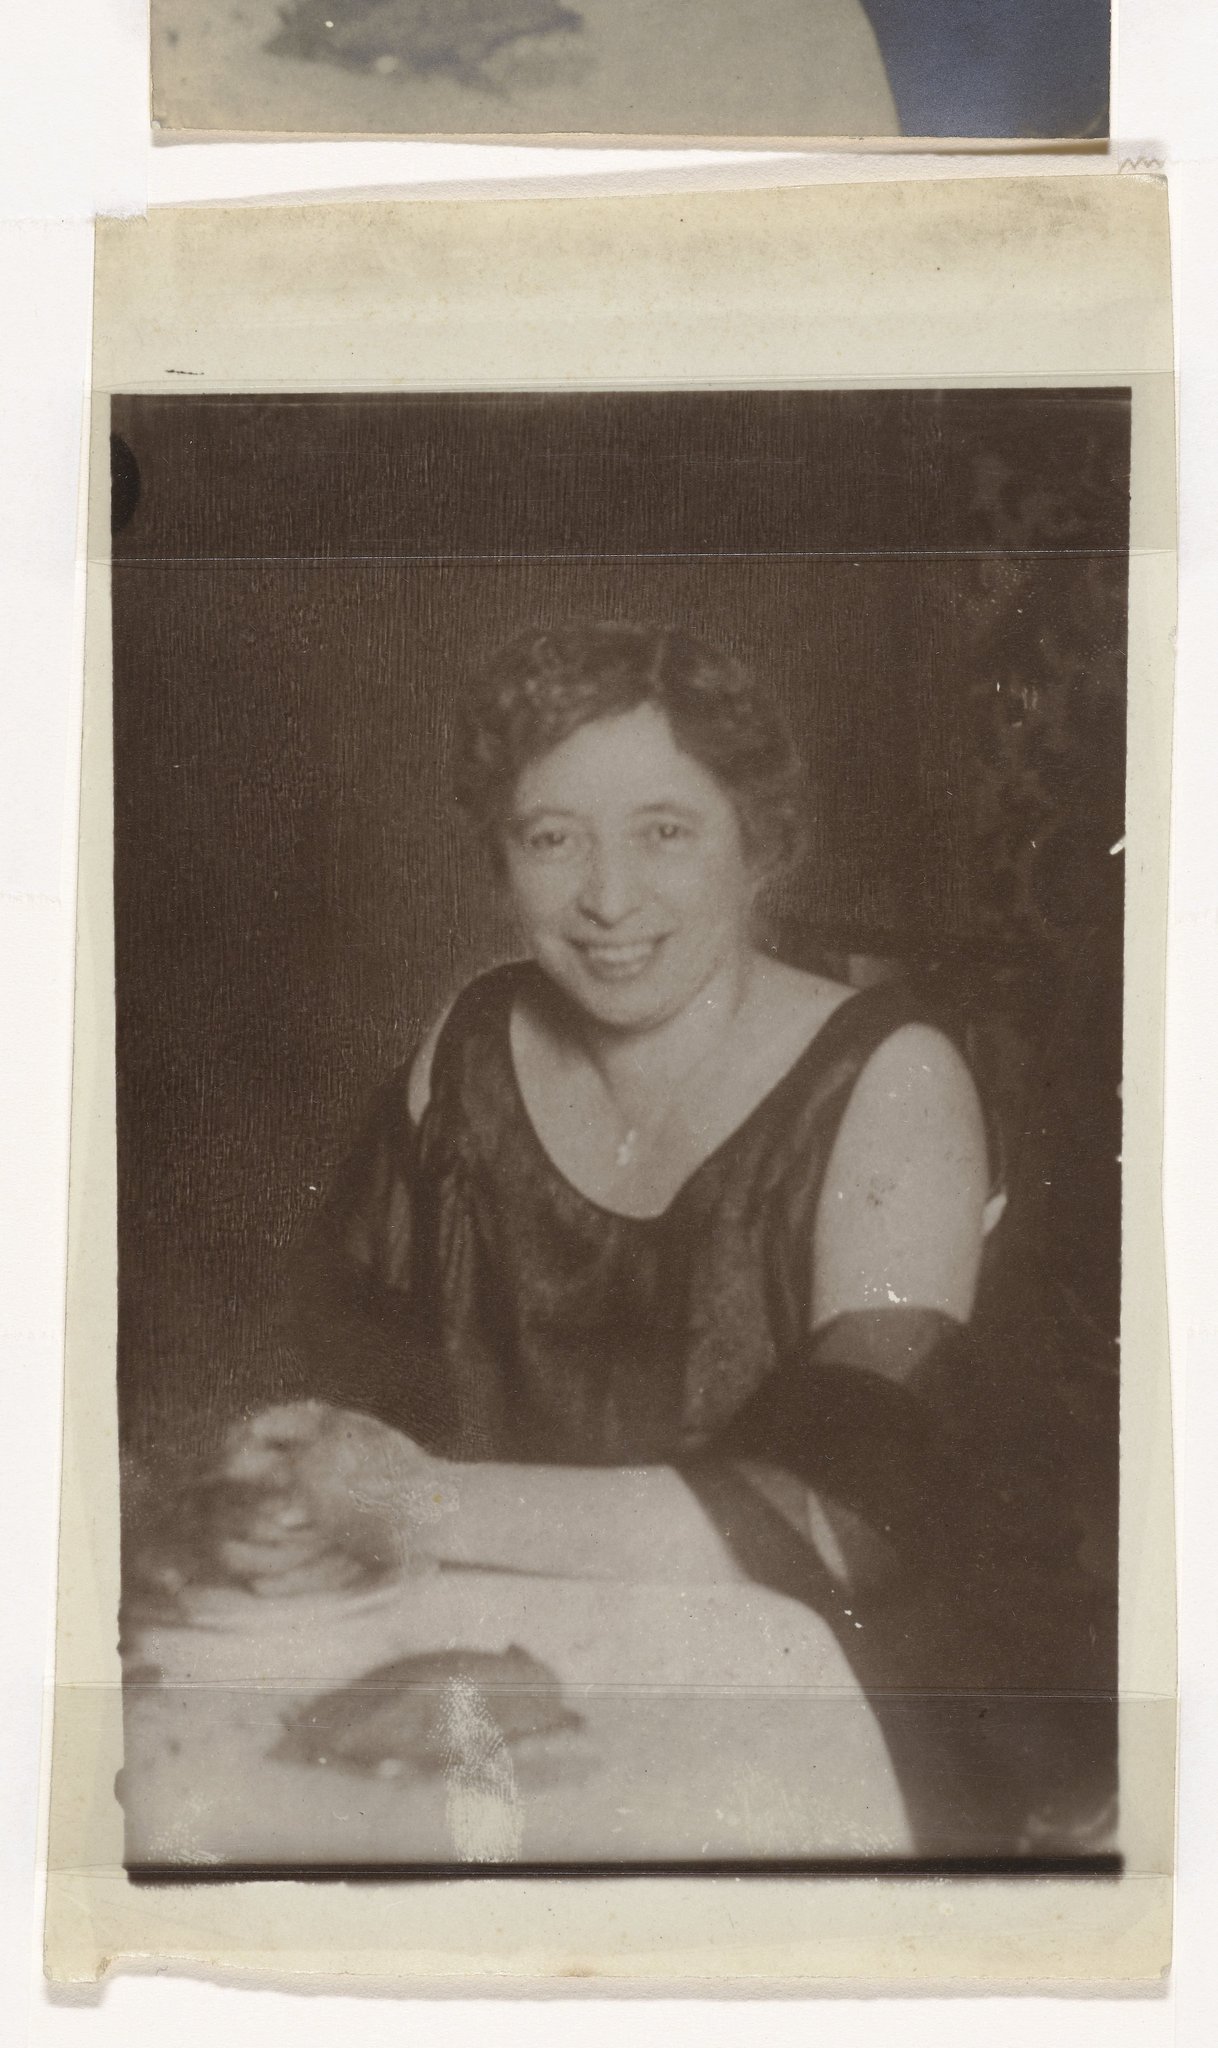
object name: photograph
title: Portret van een oudere vrouw aan tafel in gala jurk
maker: jacob merkelbach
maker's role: fotograaf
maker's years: 1877-1942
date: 1915-1930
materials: paper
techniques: carbon print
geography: amsterdam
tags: historical persons not known by name - bb - woman